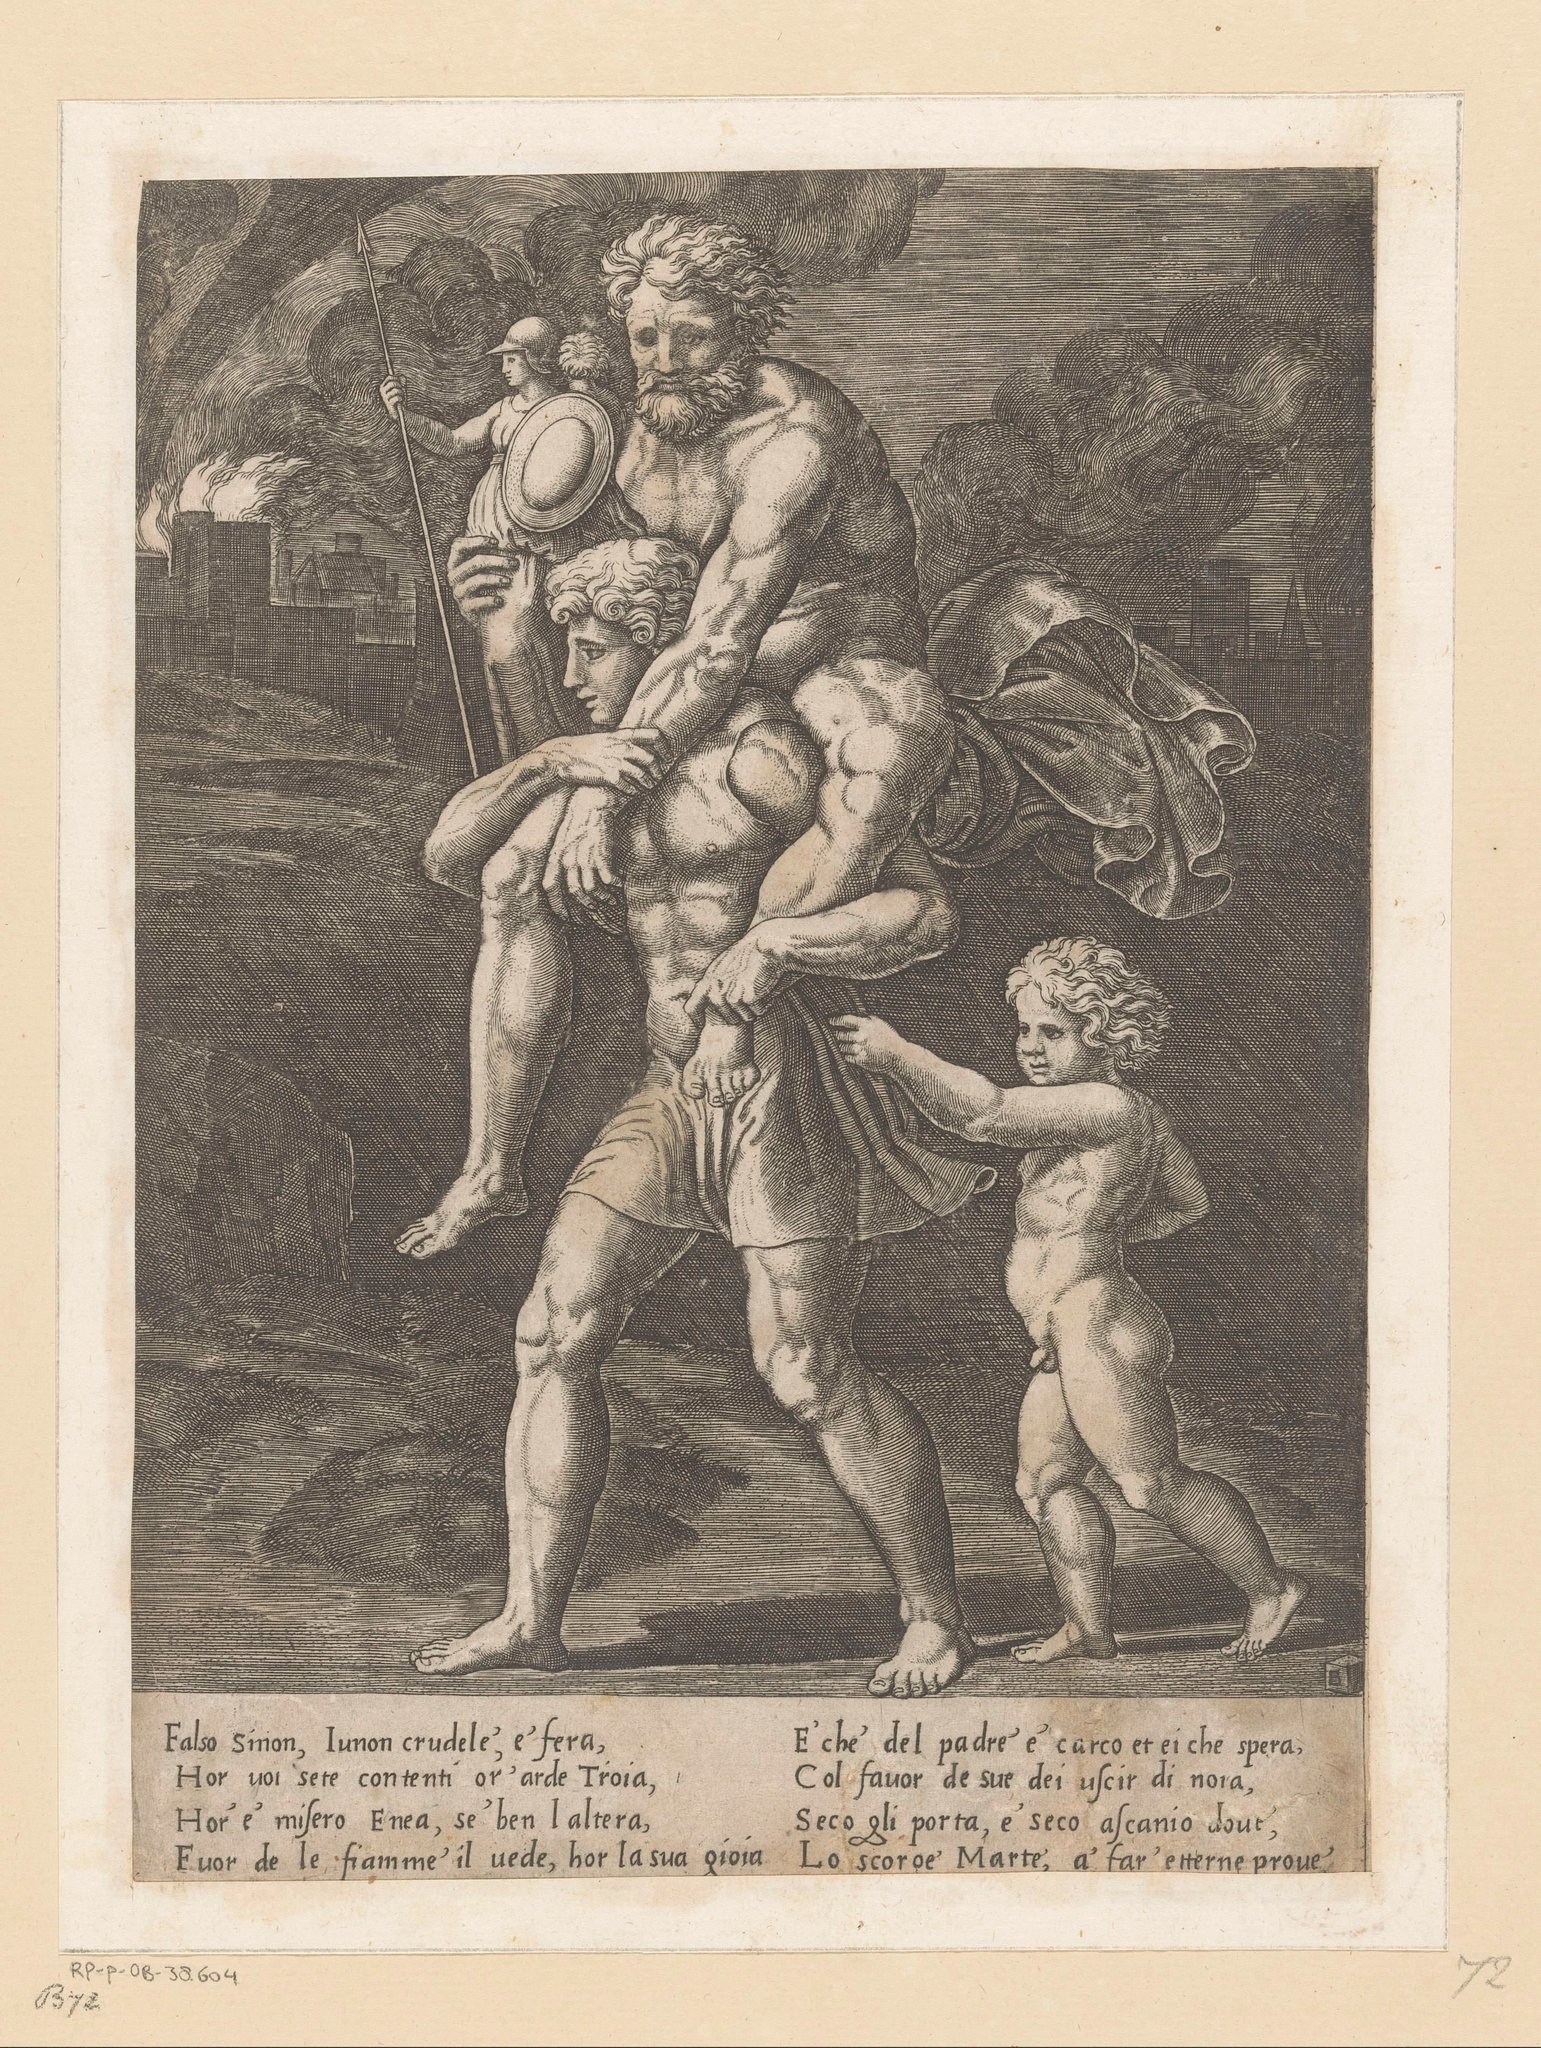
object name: print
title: Aeneas en zijn familie vluchten uit Troje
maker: meester van de dobbelsteen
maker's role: print maker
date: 1530-1560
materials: paper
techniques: engraving, intaglio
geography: italy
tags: 'pius aeneas': aeneas, leading ascanius, escapes from burning troy, carrying his father anchises with the penates; his wife creusa, who sets out with them, is lost on the way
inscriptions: collector's mark: Lugt 240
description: Aeneas loopt met zijn vader Anchises op de rug. In zijn rechterhand draagt Anchises de huisgoden (Penates). Achter Aeneas loopt zijn zoon Ascanius. Op de achtergrond het brandende Troje. Italiaanse tekst in twee kolommen in ondermarge.